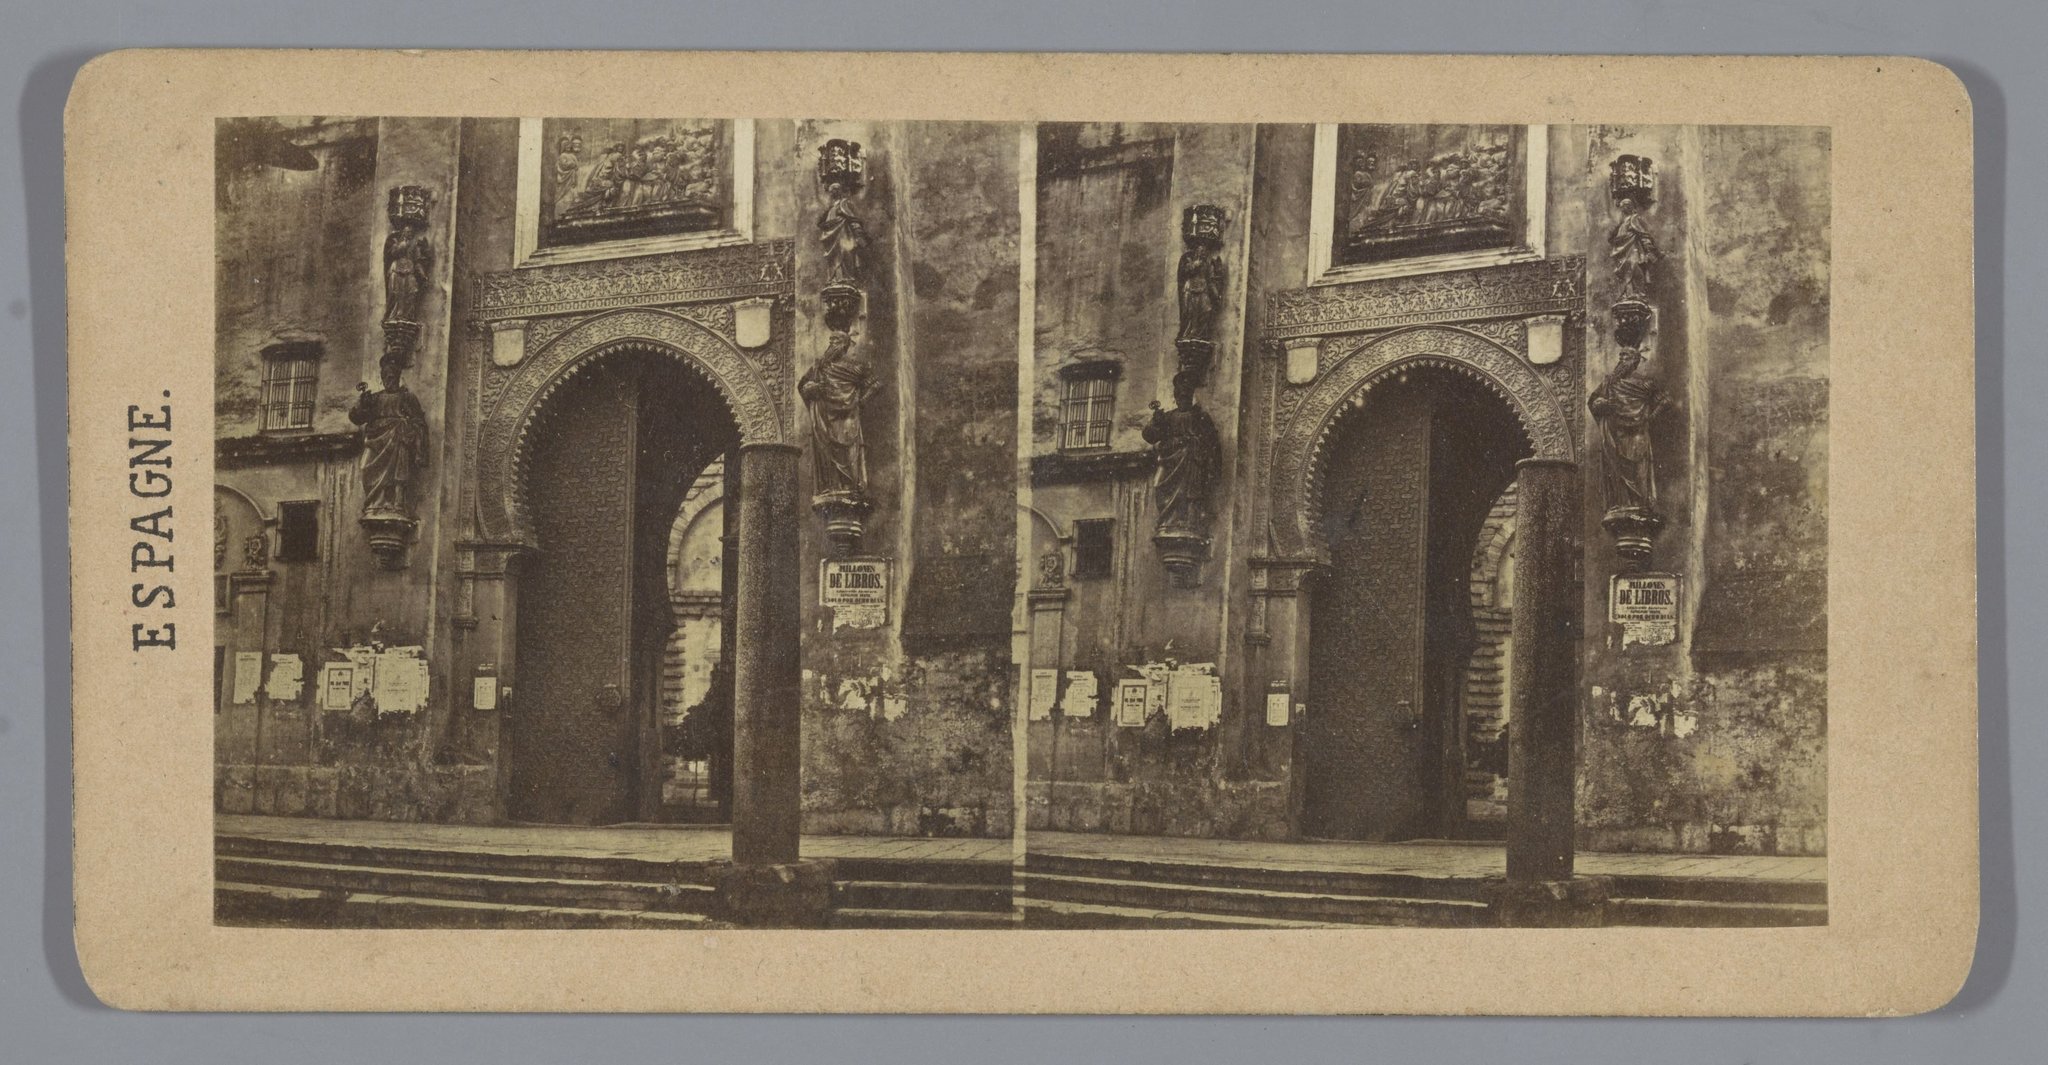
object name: stereograph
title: Porte du Pardon dans la Cour des Orangers, à Séville.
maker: Anonymous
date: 1850-1880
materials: cardboard, photographic support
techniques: albumen print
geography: sevilla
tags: church (exterior), gate, entrance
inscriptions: inscription: ‘Espagne.’, number: ‘No 184.’